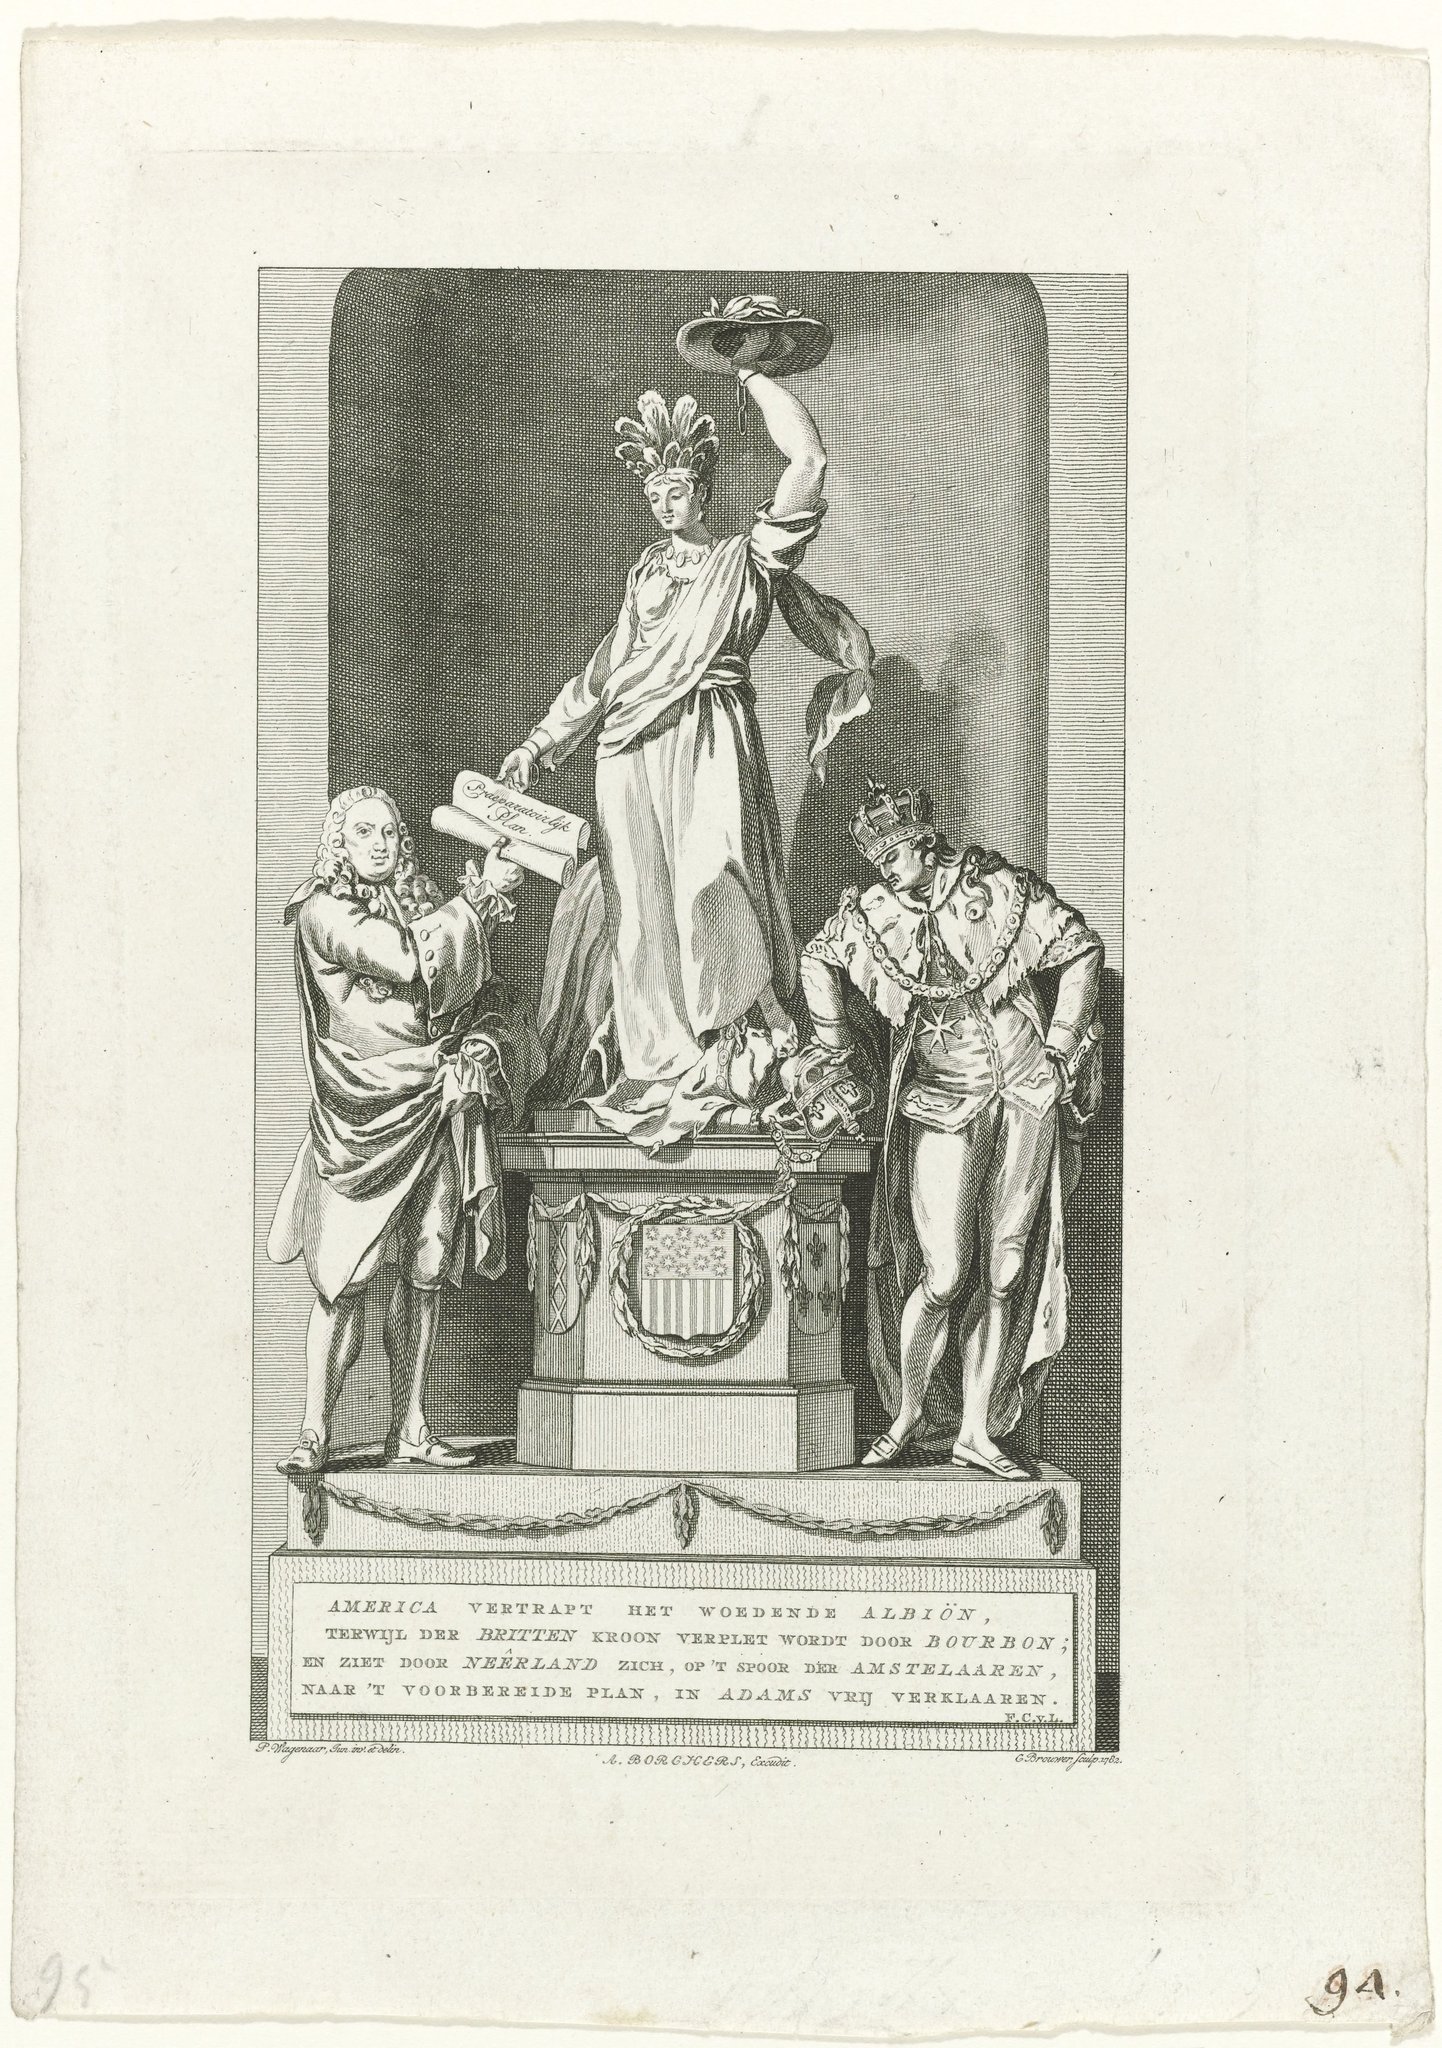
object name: print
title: Allegorie op het verbond van Nederland met Amerika, 1782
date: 1782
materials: paper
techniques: engraving, etching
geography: northern netherlands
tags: rotterdam, mayor, personifications of countries, nations, states, districts, etc., netherlands, united states of america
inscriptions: collector's mark: Lugt 2228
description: Allegorie op de erkenning van John Adams als officiële vertegenwoordiger van de Verenigde Staten in Nederland, 7 oktober 1782. Standbeeld van Amerika met op het hoofd een verentooi en in de hand de vrijheidshoed, zij vertrapt Albion terwijl Frankrijk (Bourbon) de Engelse kroon verplettert. Amerika staat op een voetstuk versierd met de wapens van Amsterdam, Frankrijk en de vlag van de Verenigde Staten. Rechts biedt een Nederlander (waarschijnlijk Pieter Johan van Berckel) haar een document gemerkt: Praeparatoirlijk Plan. Op het voetstuk een vierregelig vers.